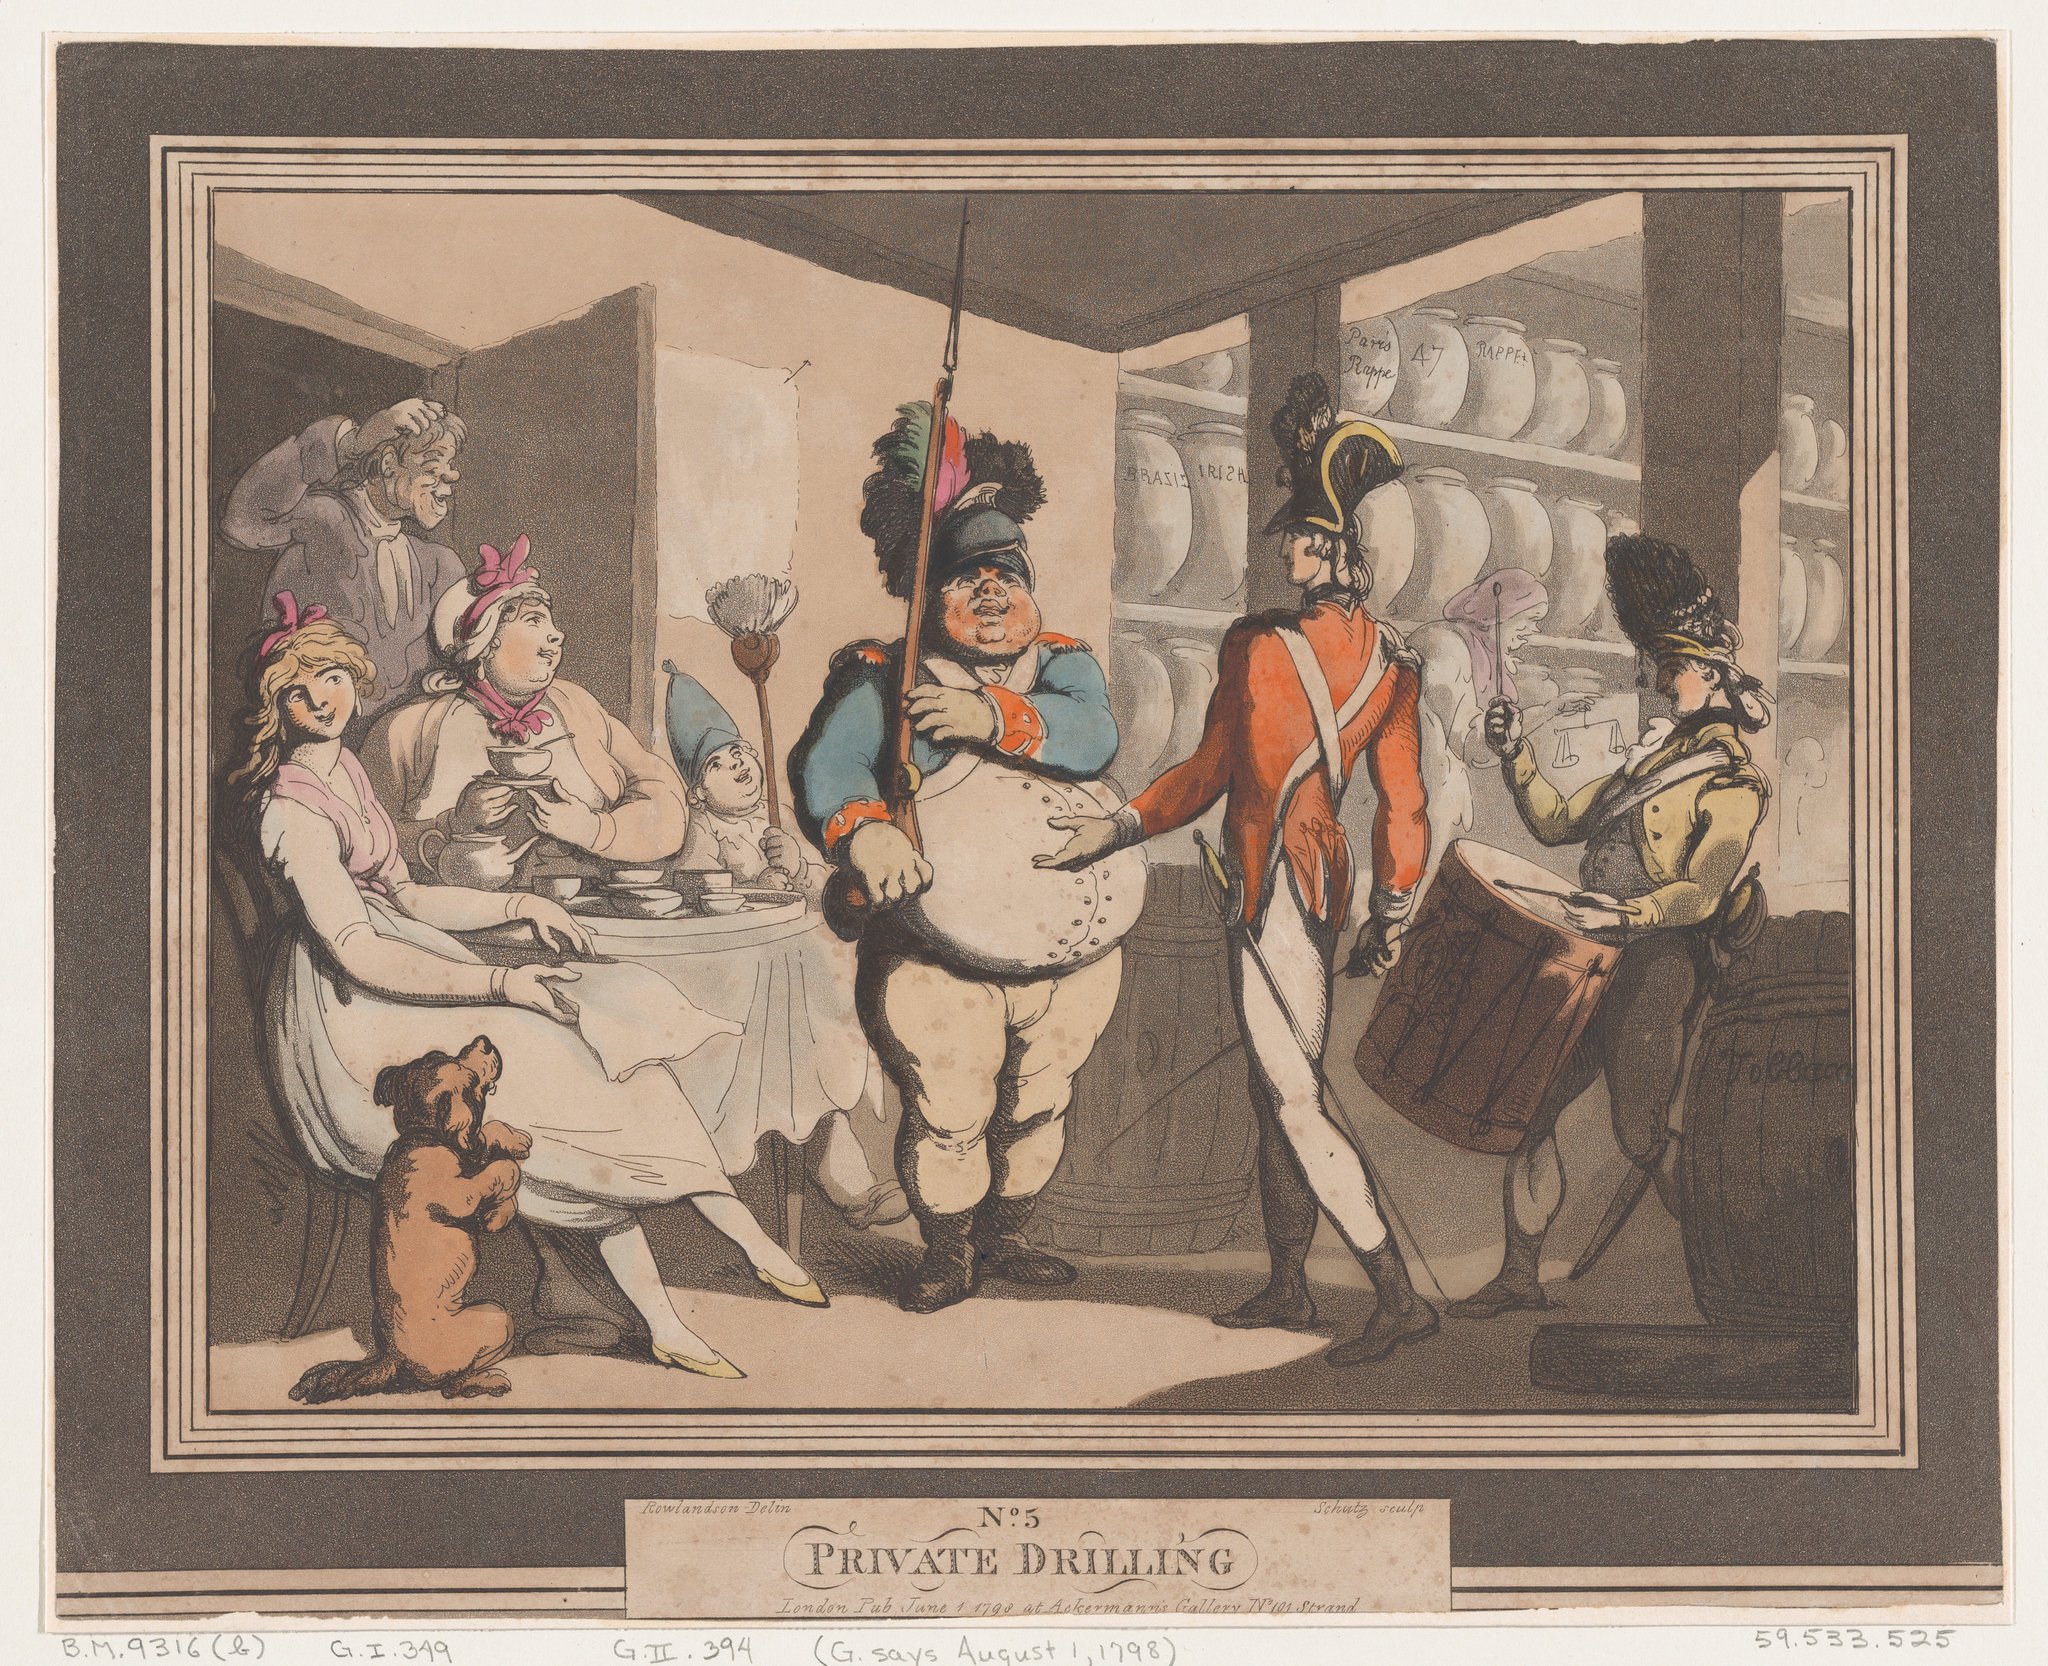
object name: print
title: Private Drilling, No 5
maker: heinrich joseph schütz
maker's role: artist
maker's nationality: german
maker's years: 1800-1825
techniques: aquatint, etching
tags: men,women,drums,dogs